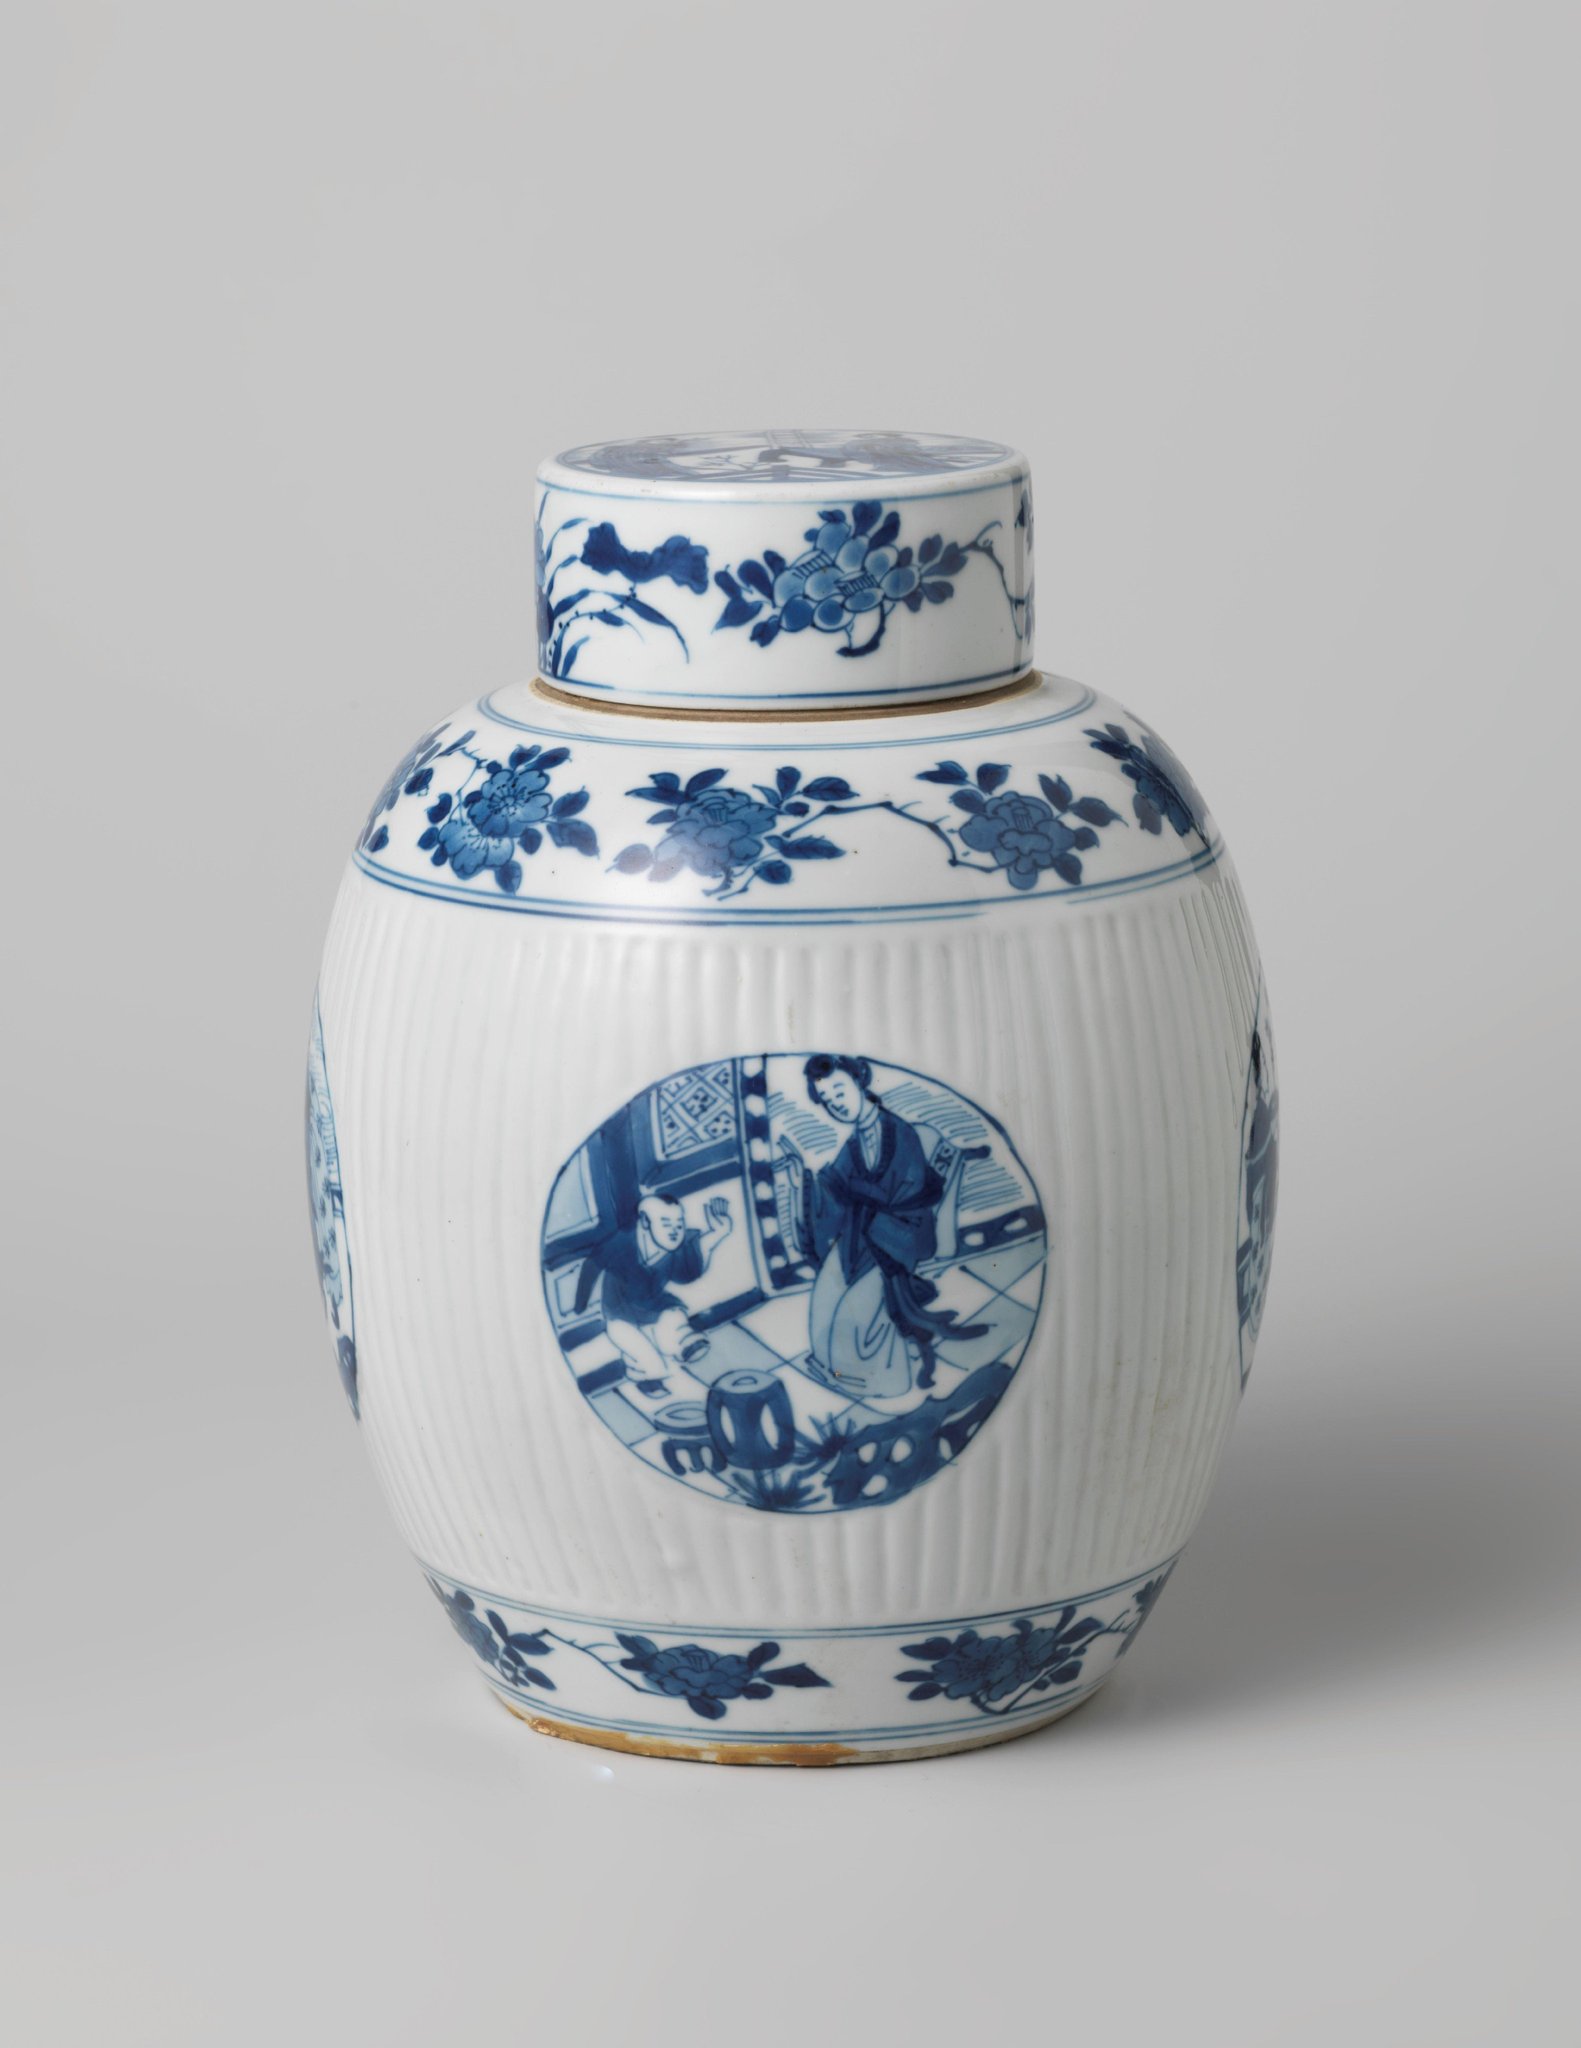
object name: ginger jar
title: Ovoid covered jar with flower sprays and narrative scenes in medallions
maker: Anonymous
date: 1680-1720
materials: cobalt, glaze, paint, porcelain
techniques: firing, forming, turning, vitrification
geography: china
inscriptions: mark: ‘大 明 成 化 年 製’